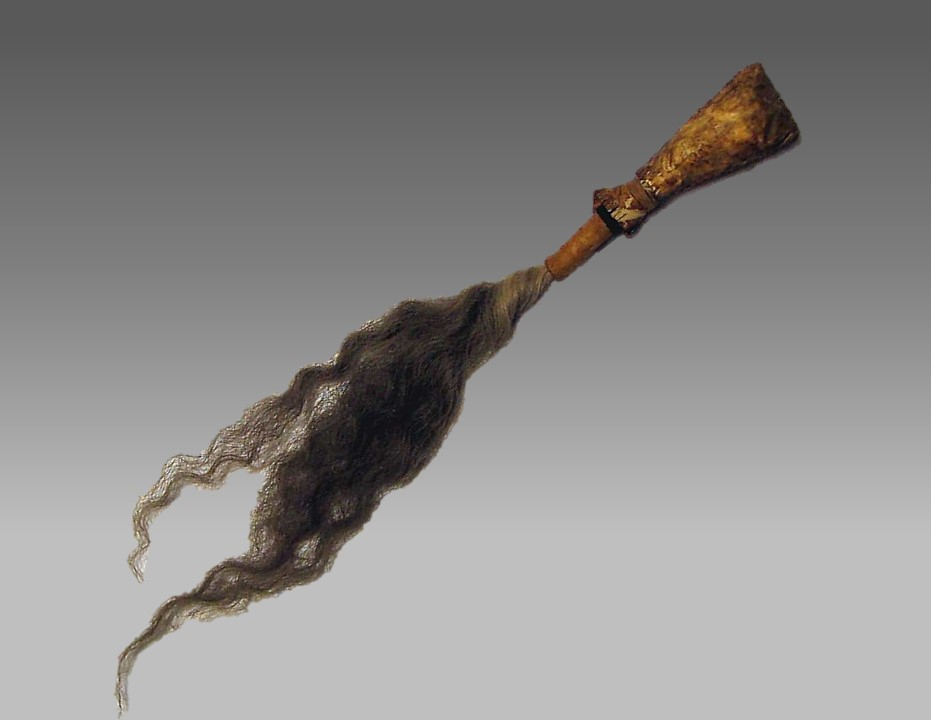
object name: rattle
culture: native american, apache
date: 1801-1900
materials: hair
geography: united states